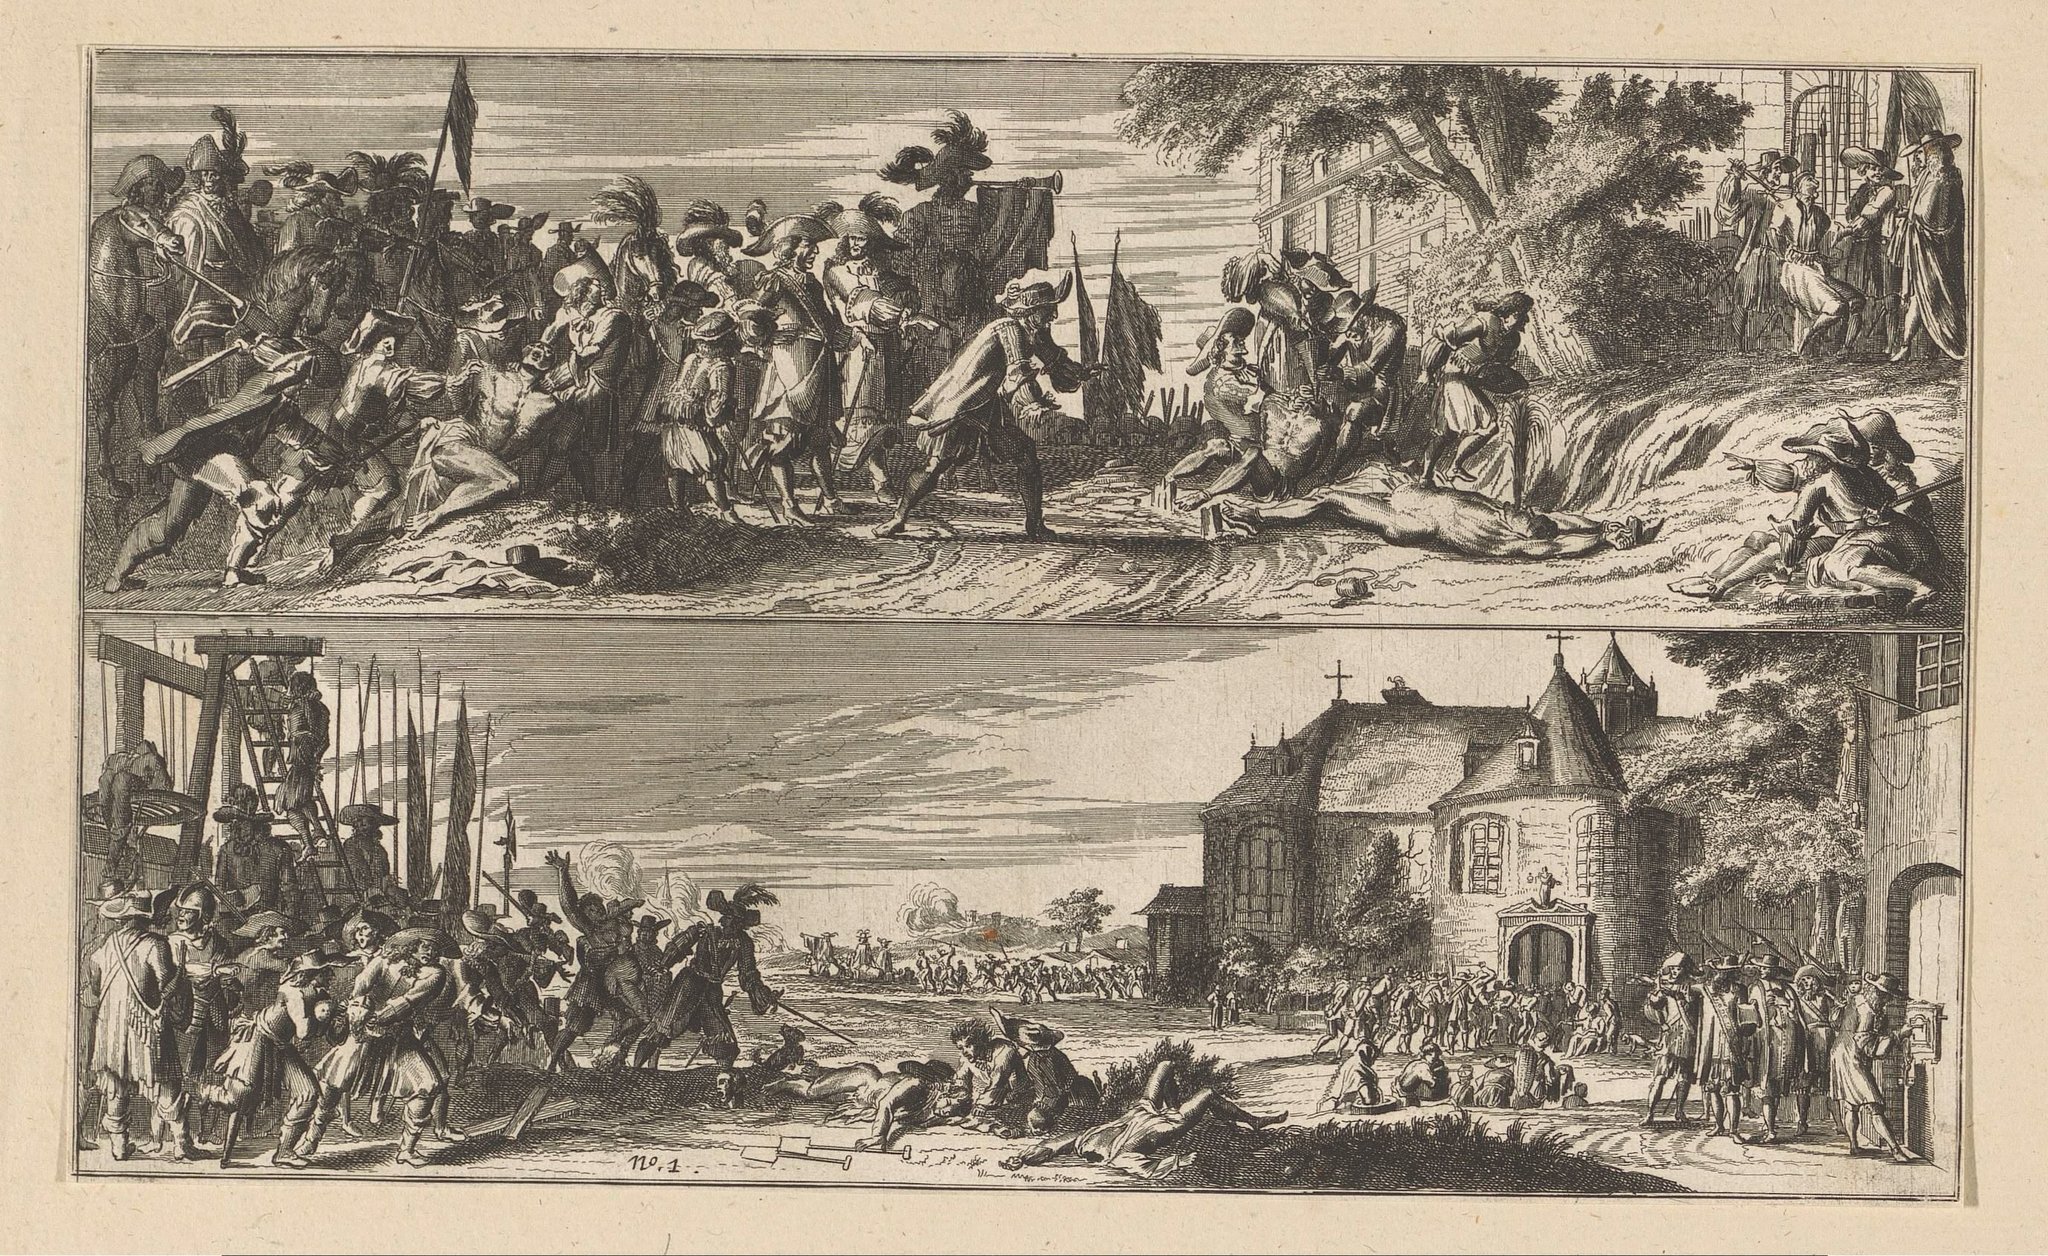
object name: print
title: Twee voorstellingen van de Franse wreedheden, 1672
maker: Anonymous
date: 1673-1677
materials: paper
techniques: engraving, etching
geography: northern netherlands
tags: violent death, being killed; being mishandled and maltreated; seeking death, massacre ~ war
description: Prent ook gebruikt in: Bosch, Lambert van den. Toneel des oorlogs, opgerecht in de Vereenigde Nederlanden; door de wapenen van de koningen van Vrankrijk en Engeland, Keulsche en Munstersche (…). 4 delen. Amsterdam: Jacob van Meurs en Johannes van Someren, 1675, dl. 3, p. 52. En in: Valckenier, Peter en Andreas Muller. Das verwirrte Europa (…). 3 delen. Amsterdam: Hendrik en Dirk Boom, Joannes van Someren en Jacob van Meurs, 1677-1683, dl. 1 (1677), p. 194 Deze prent is gekopieerd naar een prent van Romeyn de Hooghe (RP-P-OB-77.193). Die prent is gebruikt in: Wicquefort, Abraham van. Avis fidelle aux veritables hollandois. Touchant ce qui s’est passé dans les villages de Bodegrave & Swammerdam, & les cruautés inoüies, que les françois y ont exercées (…). S.l. [Den Haag]: s.n.[Daniel en Johannes Steucker], 1673.